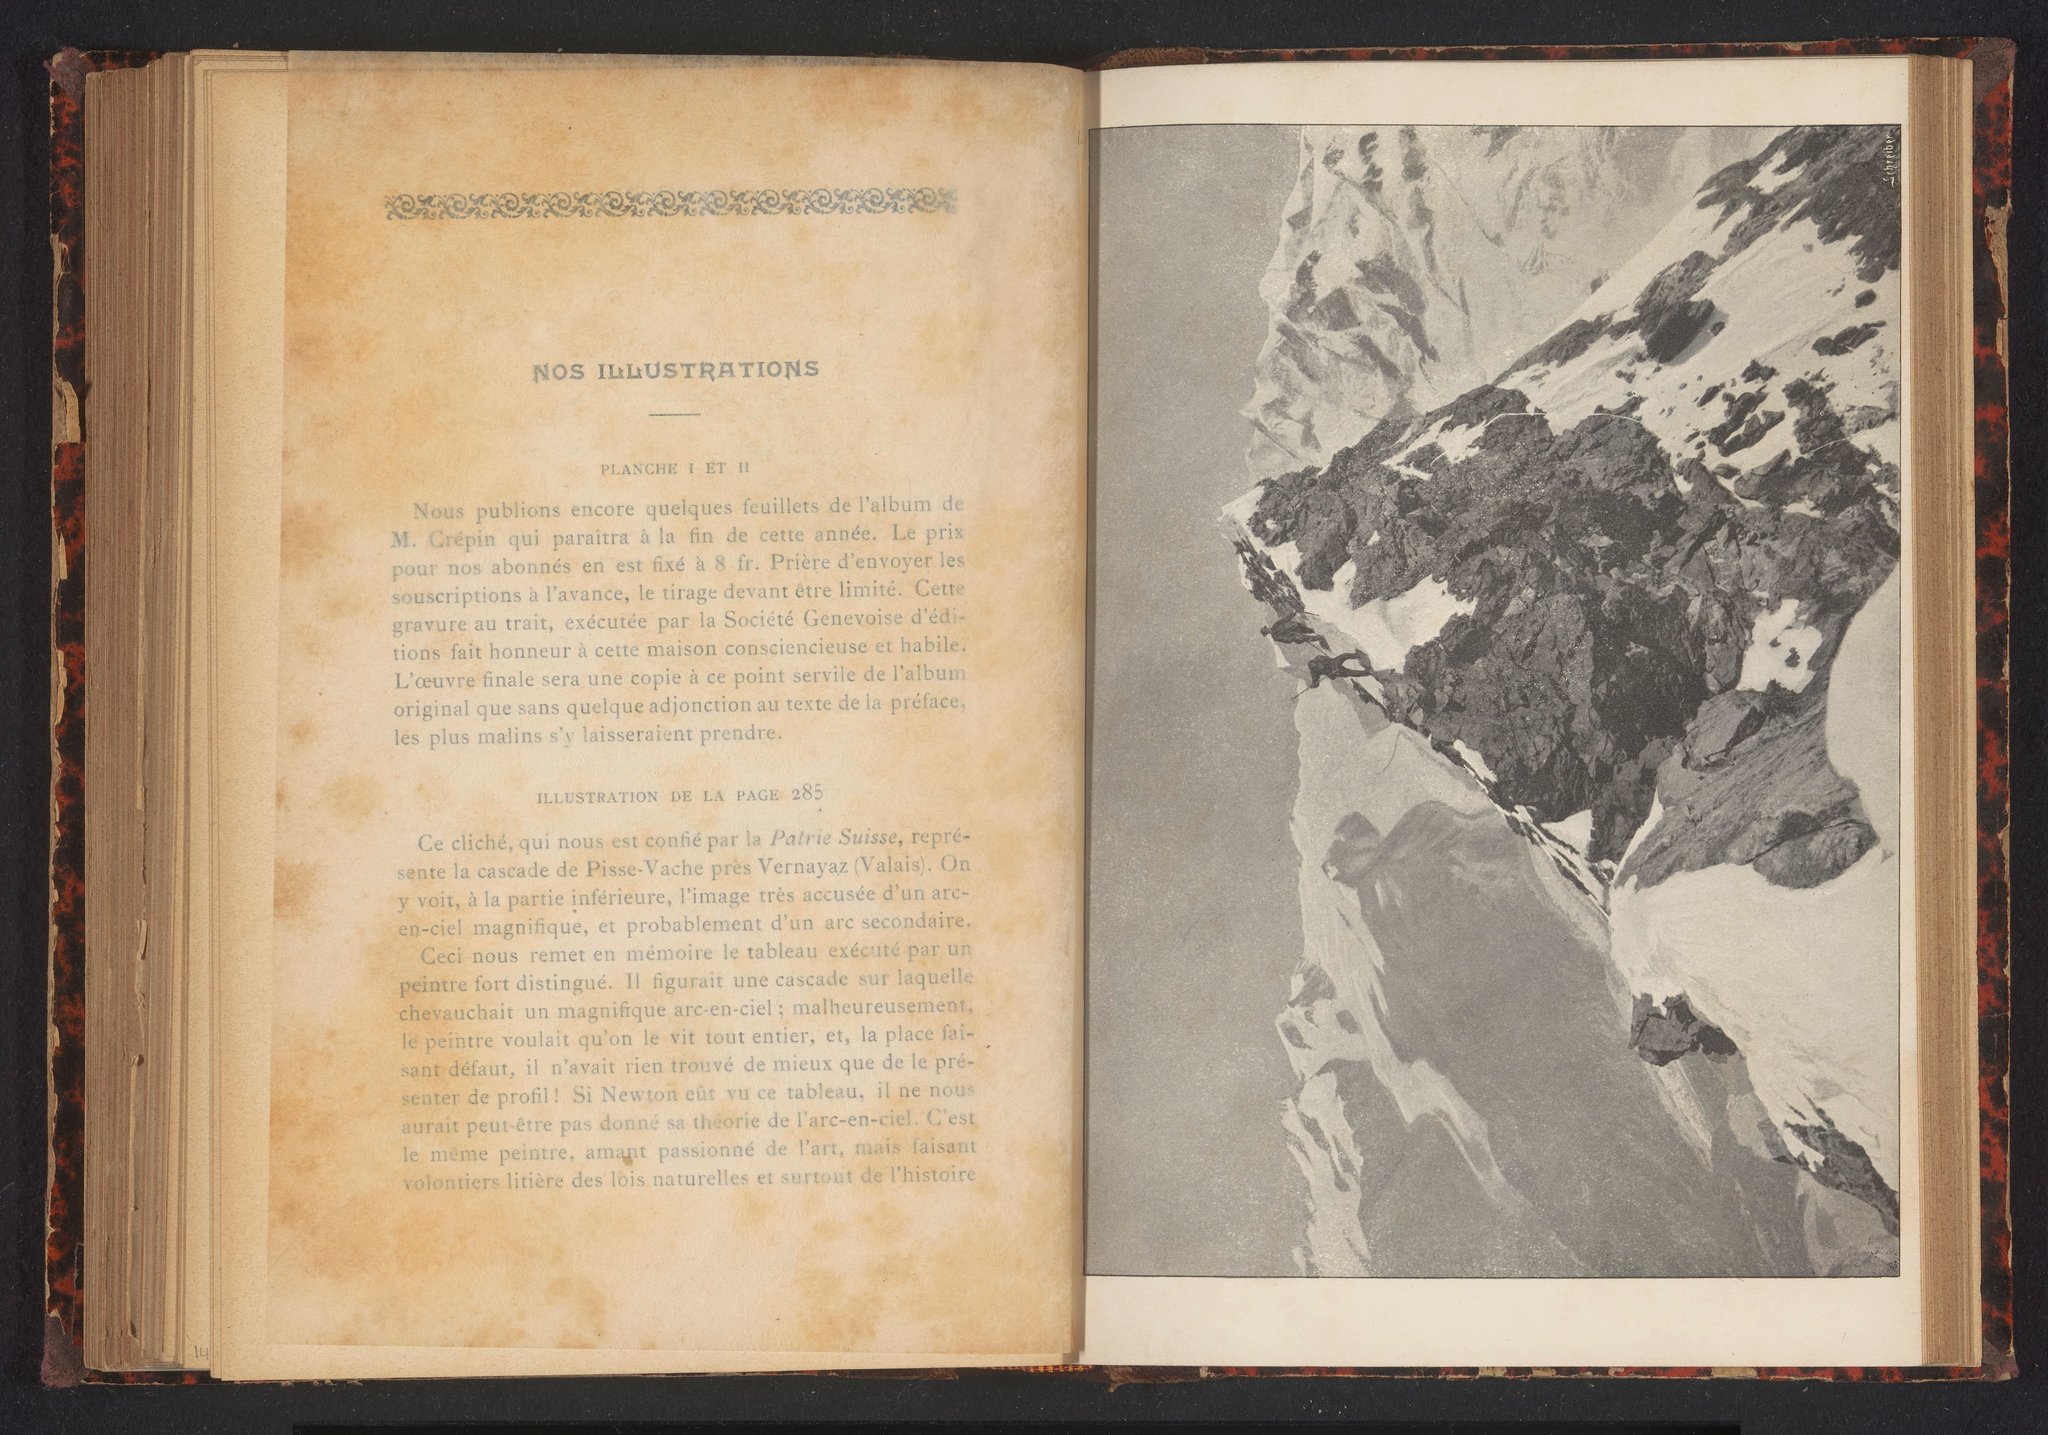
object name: photomechanical print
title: Twee bergbeklimmers op de Matterhorn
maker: schreiber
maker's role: fotograaf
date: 1895-1900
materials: paper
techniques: autotype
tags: mountain climbing, mountaineering, mountain-top, peak, mountain-range, snow peaks